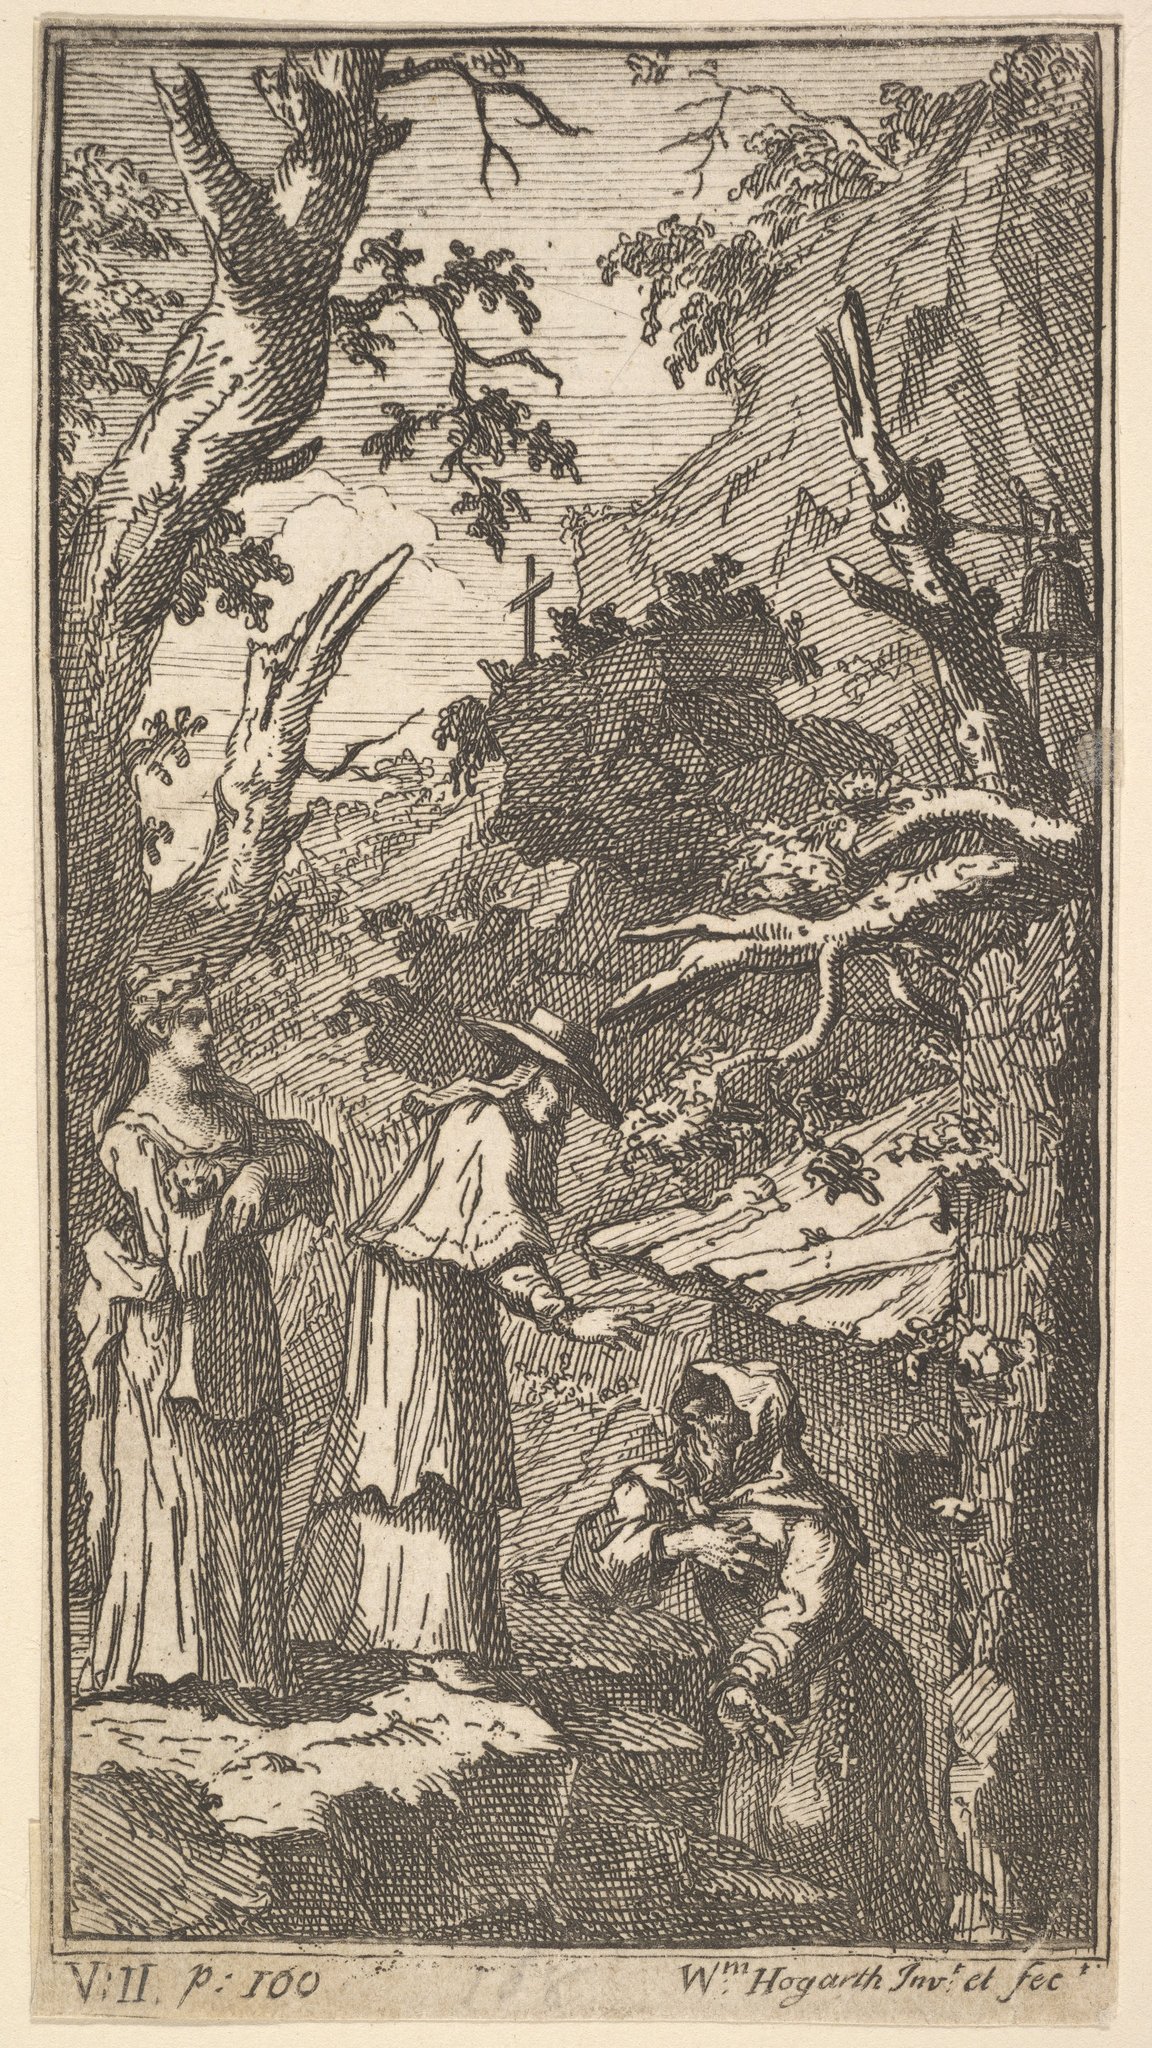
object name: print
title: The New Metamorphosis, Plate 7: The Cardinal, a Hermit and Donna Angela Holding Fantasio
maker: william hogarth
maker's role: artist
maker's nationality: british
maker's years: 1697-1764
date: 1724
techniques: engraving, etching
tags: animals,men,women,trees